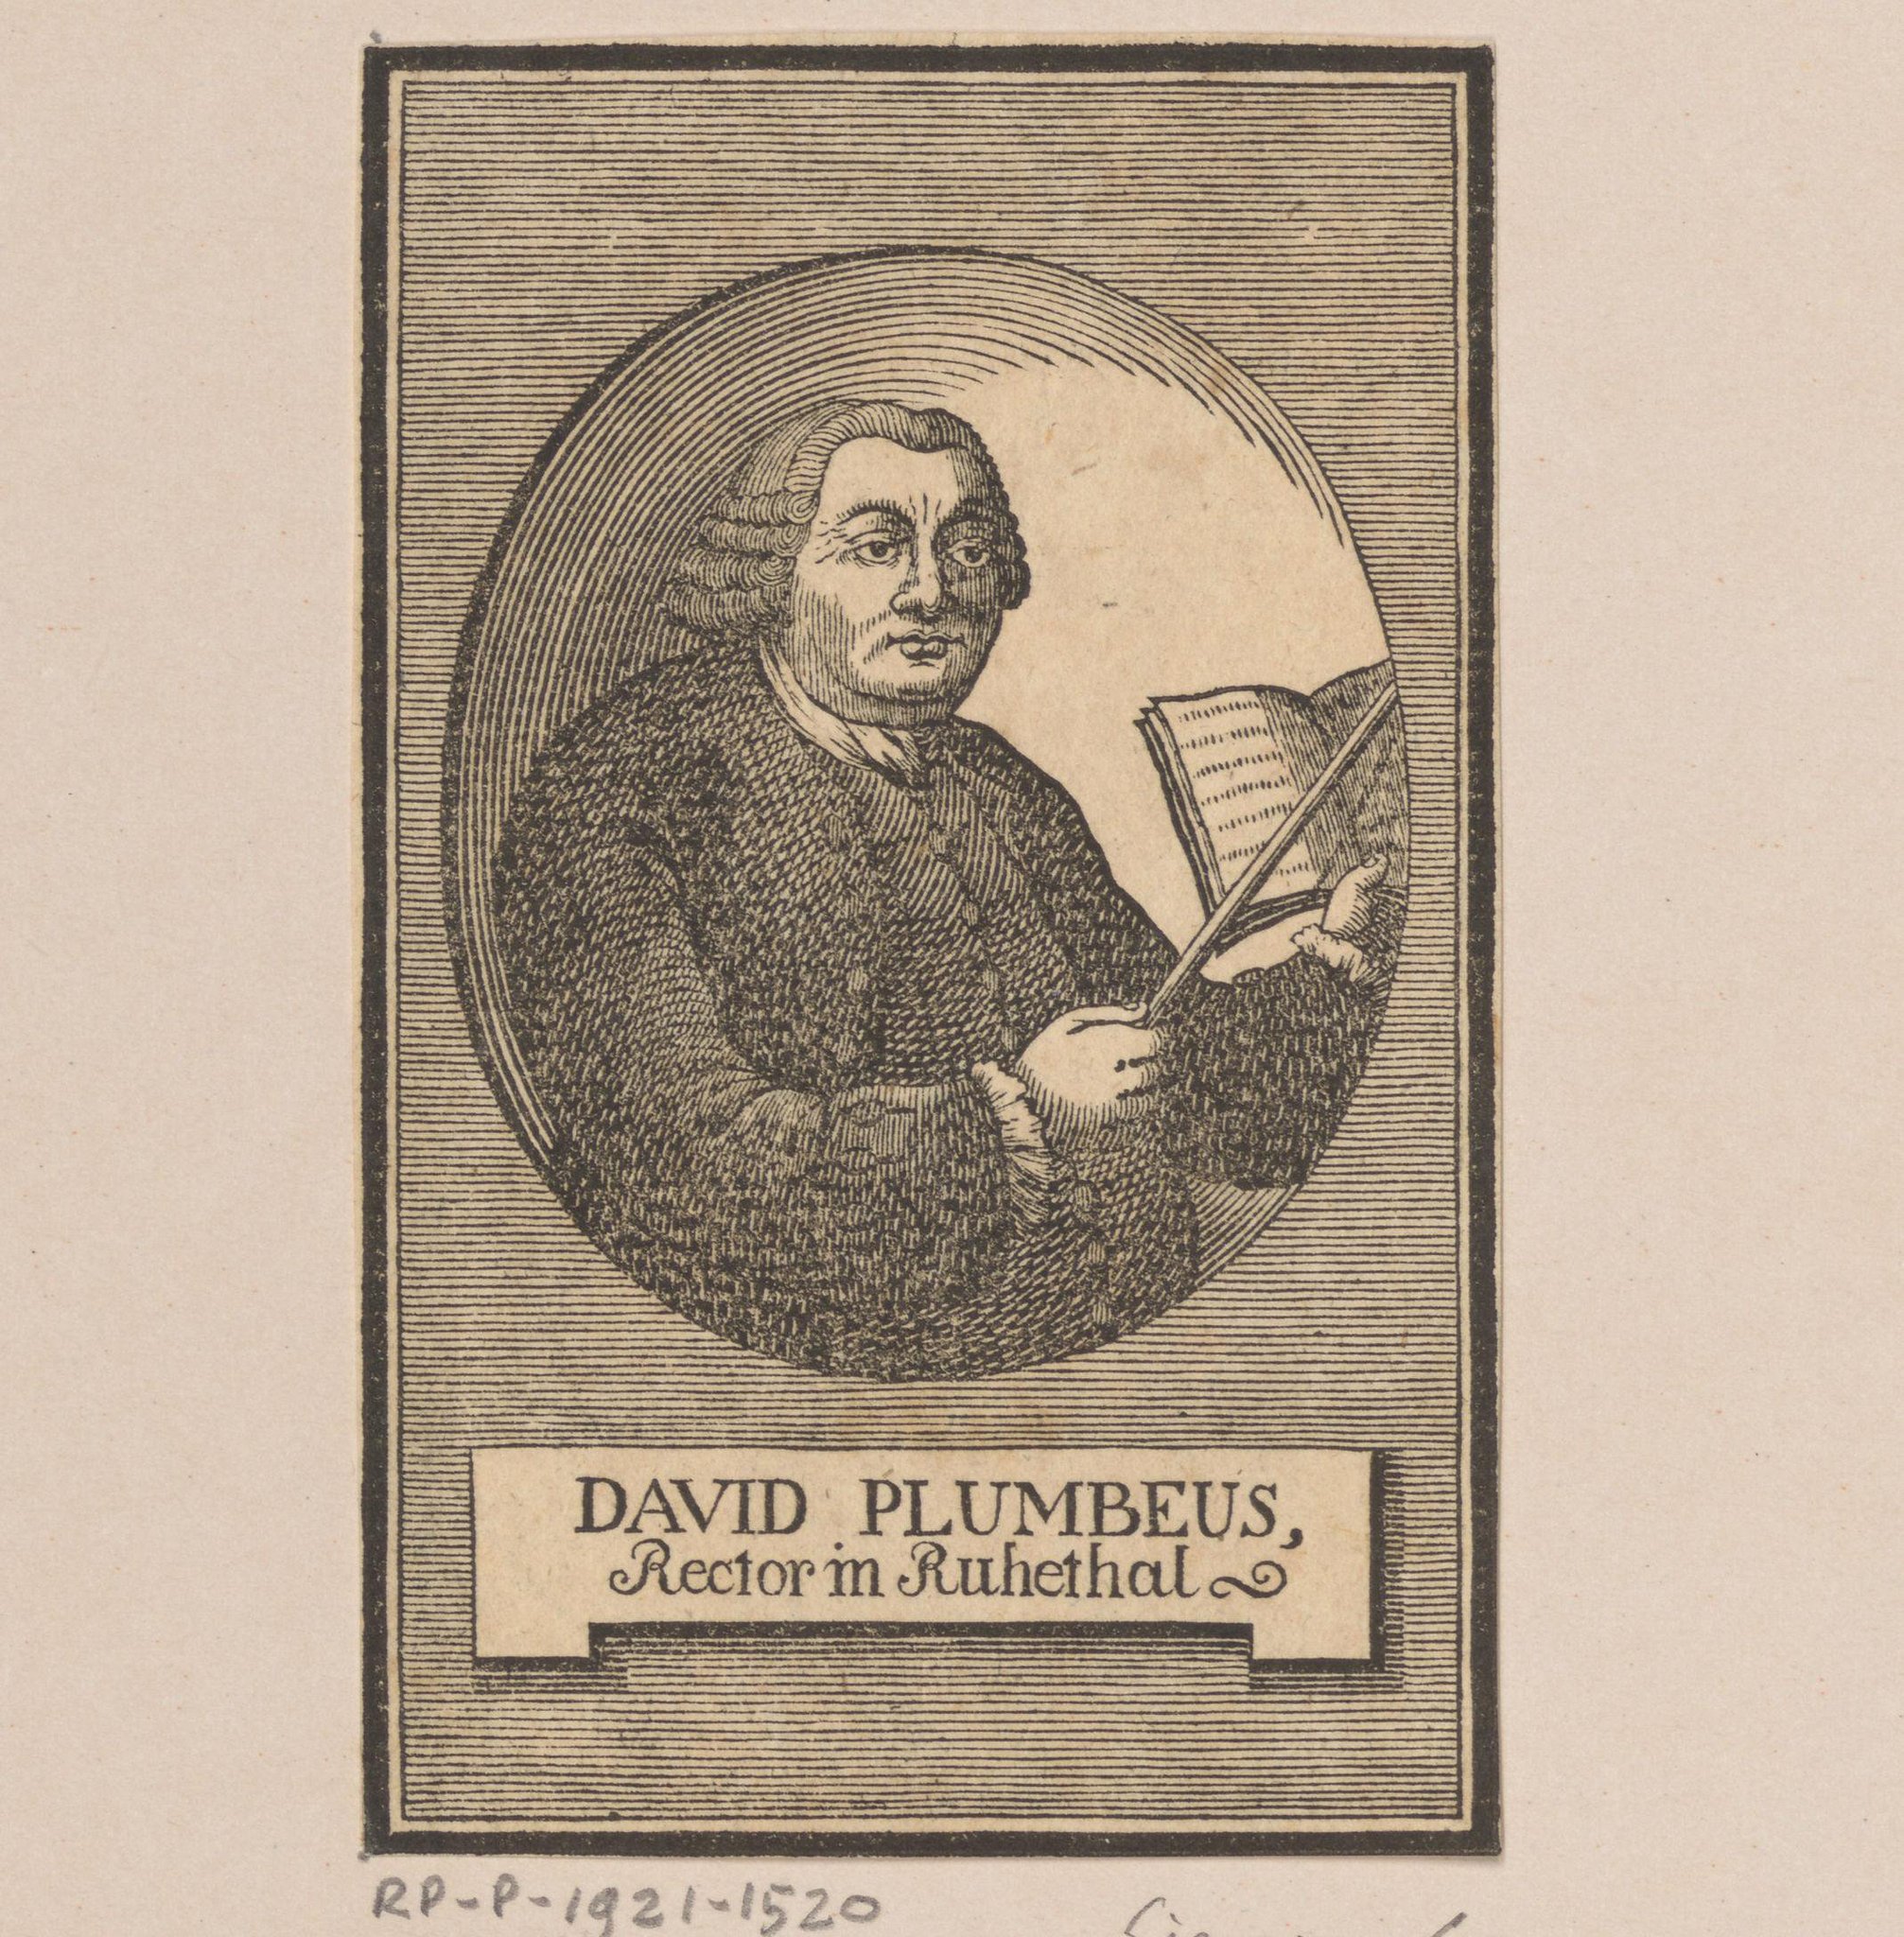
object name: print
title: Portret van David Plumbeus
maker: Anonymous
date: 1785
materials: paper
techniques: woodcut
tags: historical persons, book - mm - book open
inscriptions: collector's mark: Lugt 2233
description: Prent waarschijnlijk uit: Journal aus Urfstädt. Frankfurt am Main: Andreaeischen Verlage, 1785, dl. 1.